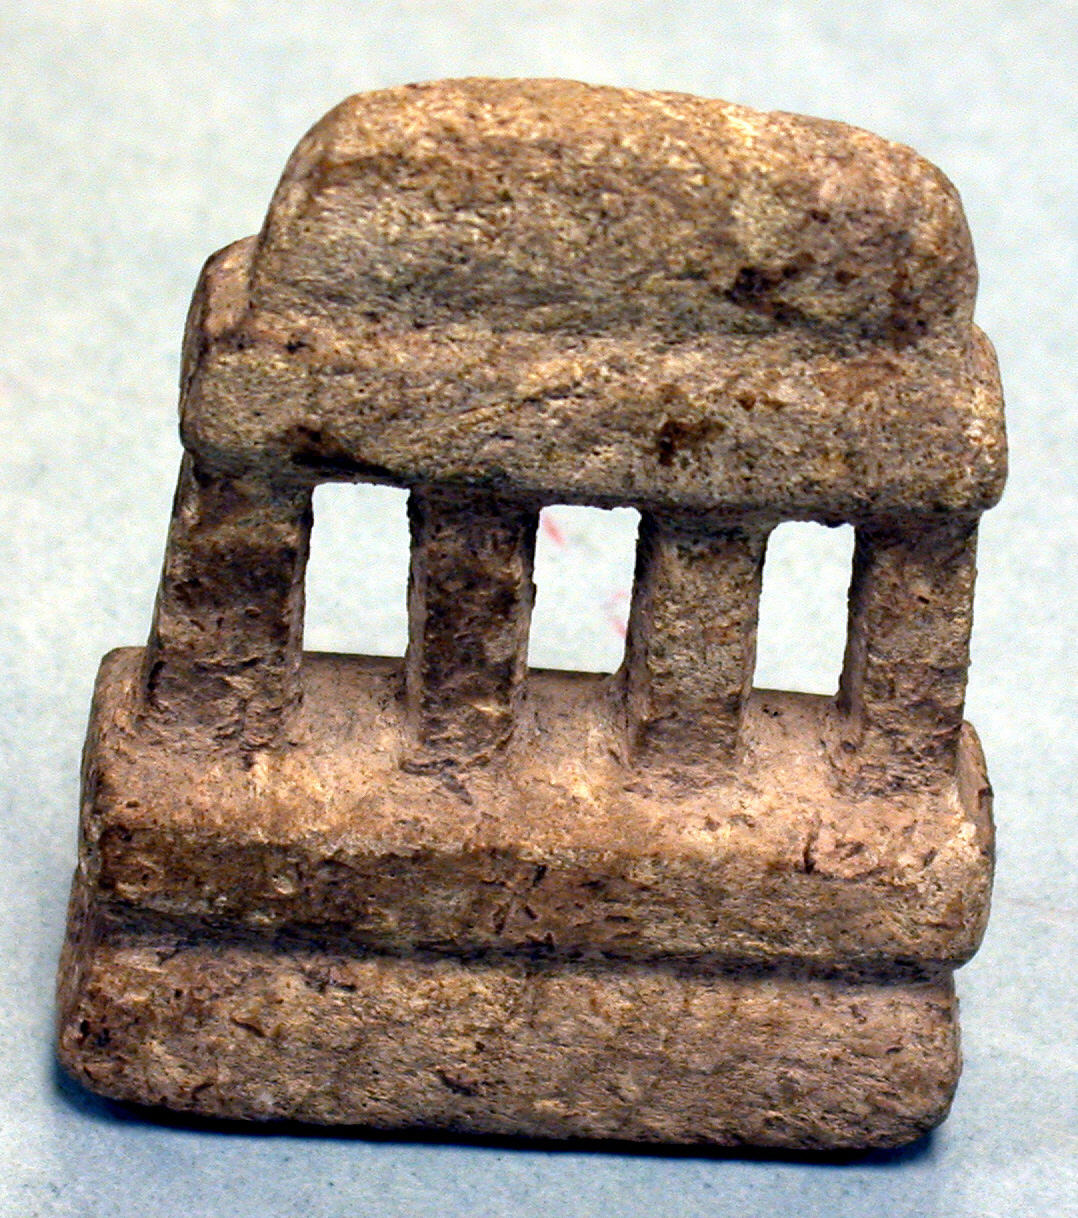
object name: architectural model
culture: mezcala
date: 1-800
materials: stone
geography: mexico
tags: temples